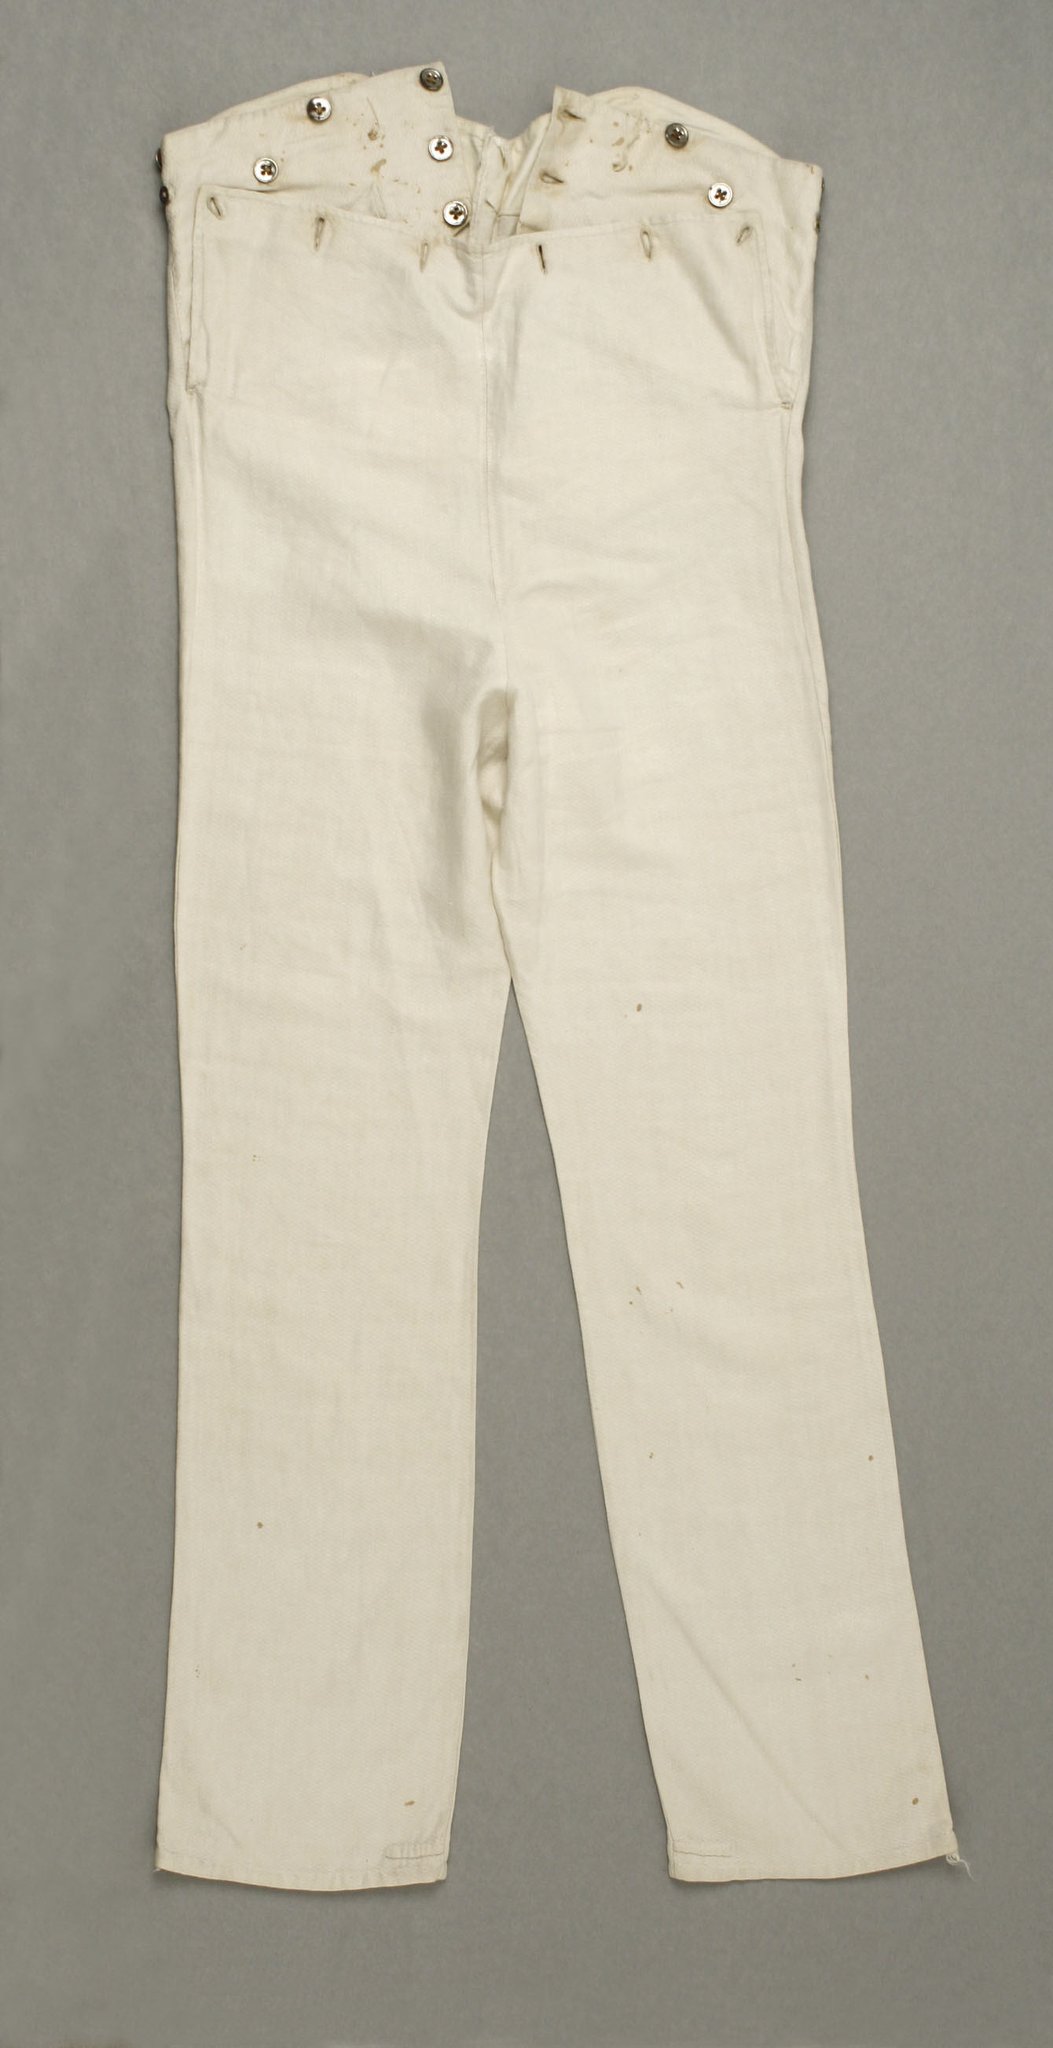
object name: pantaloon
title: Pantaloons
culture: american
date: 1830-1840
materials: linen